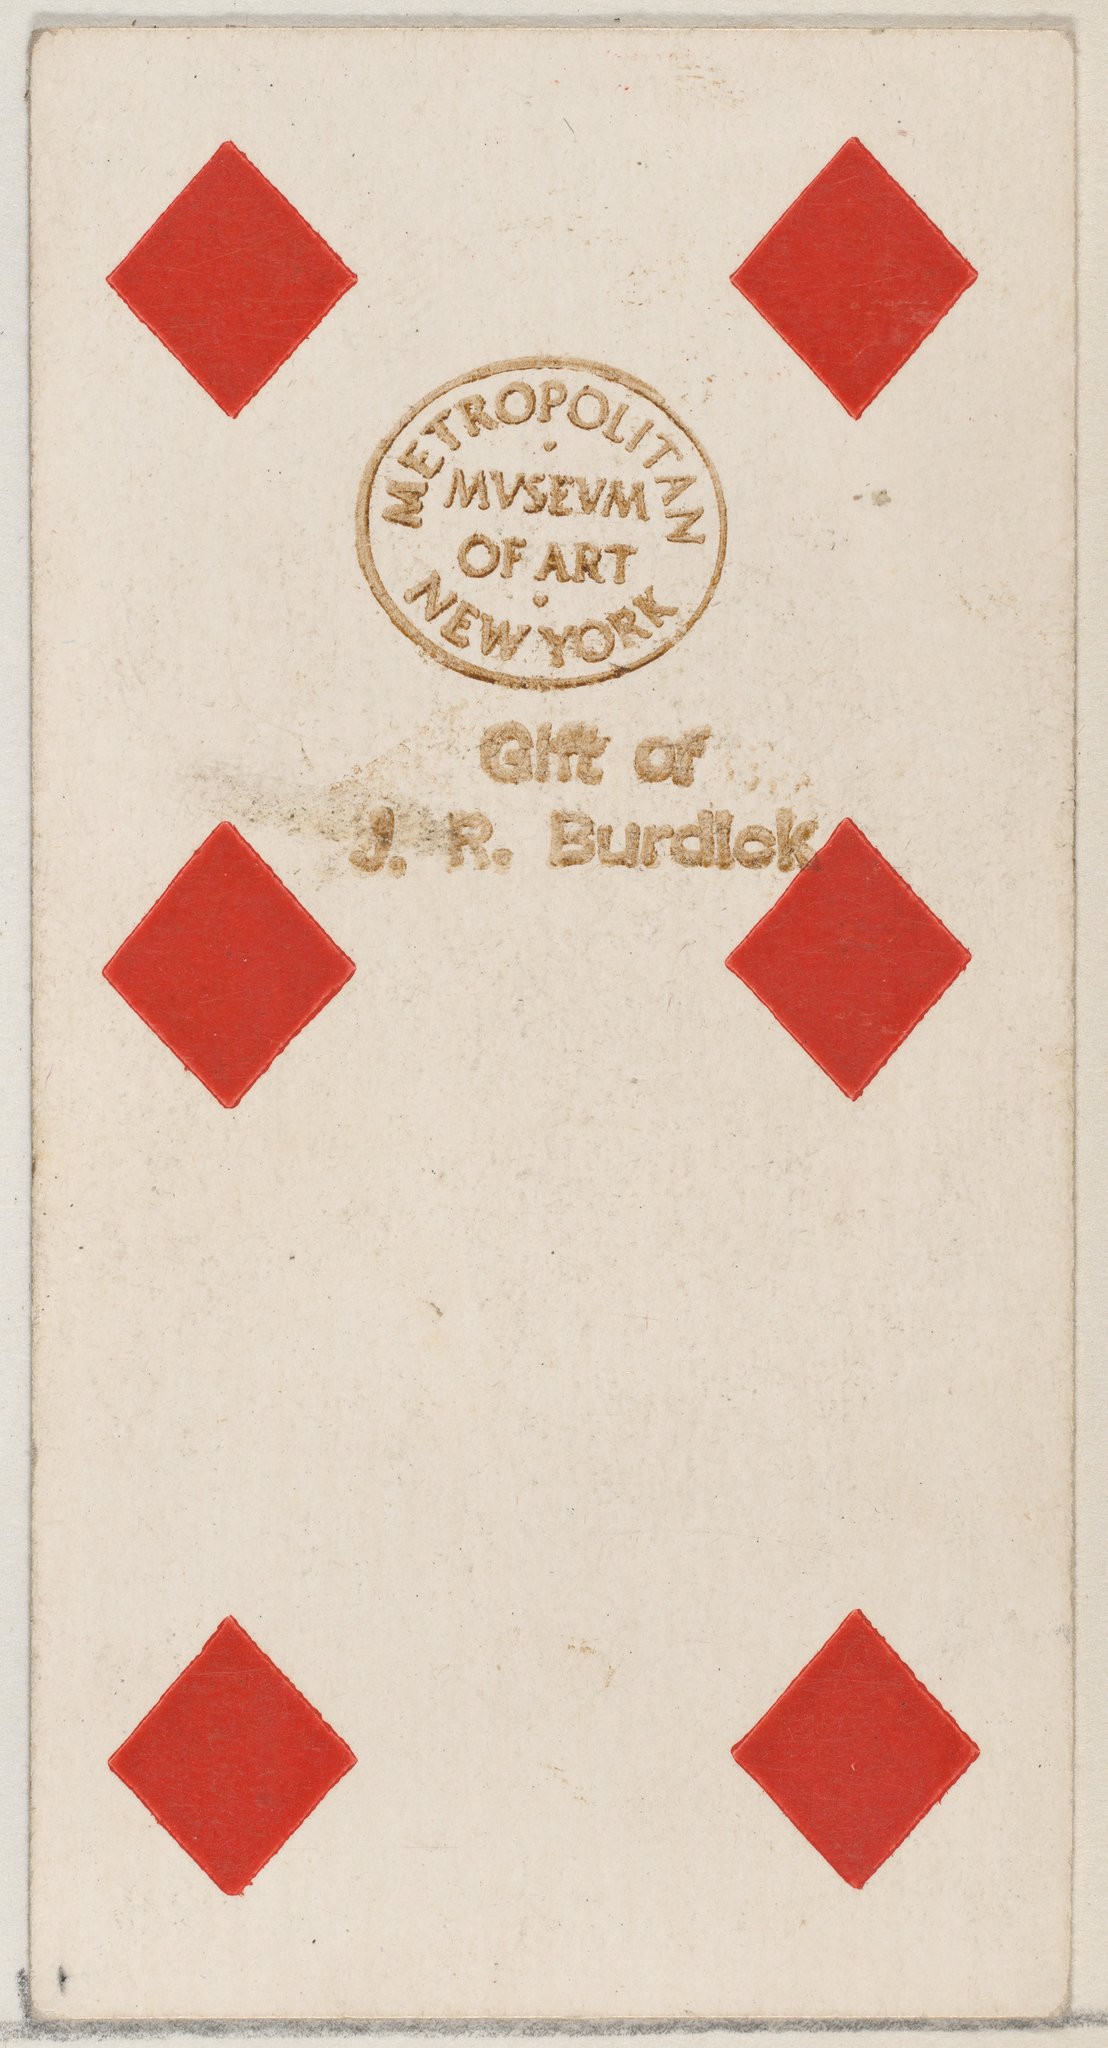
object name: print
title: Six Diamonds, from the Playing Cards series (N84) to promote Turkish Cross-Cut Cigarettes for W. Duke, Sons and Co.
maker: w. duke, sons & co.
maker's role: publisher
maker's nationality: american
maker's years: 1870-1920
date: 1888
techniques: color lithograph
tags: playing cards